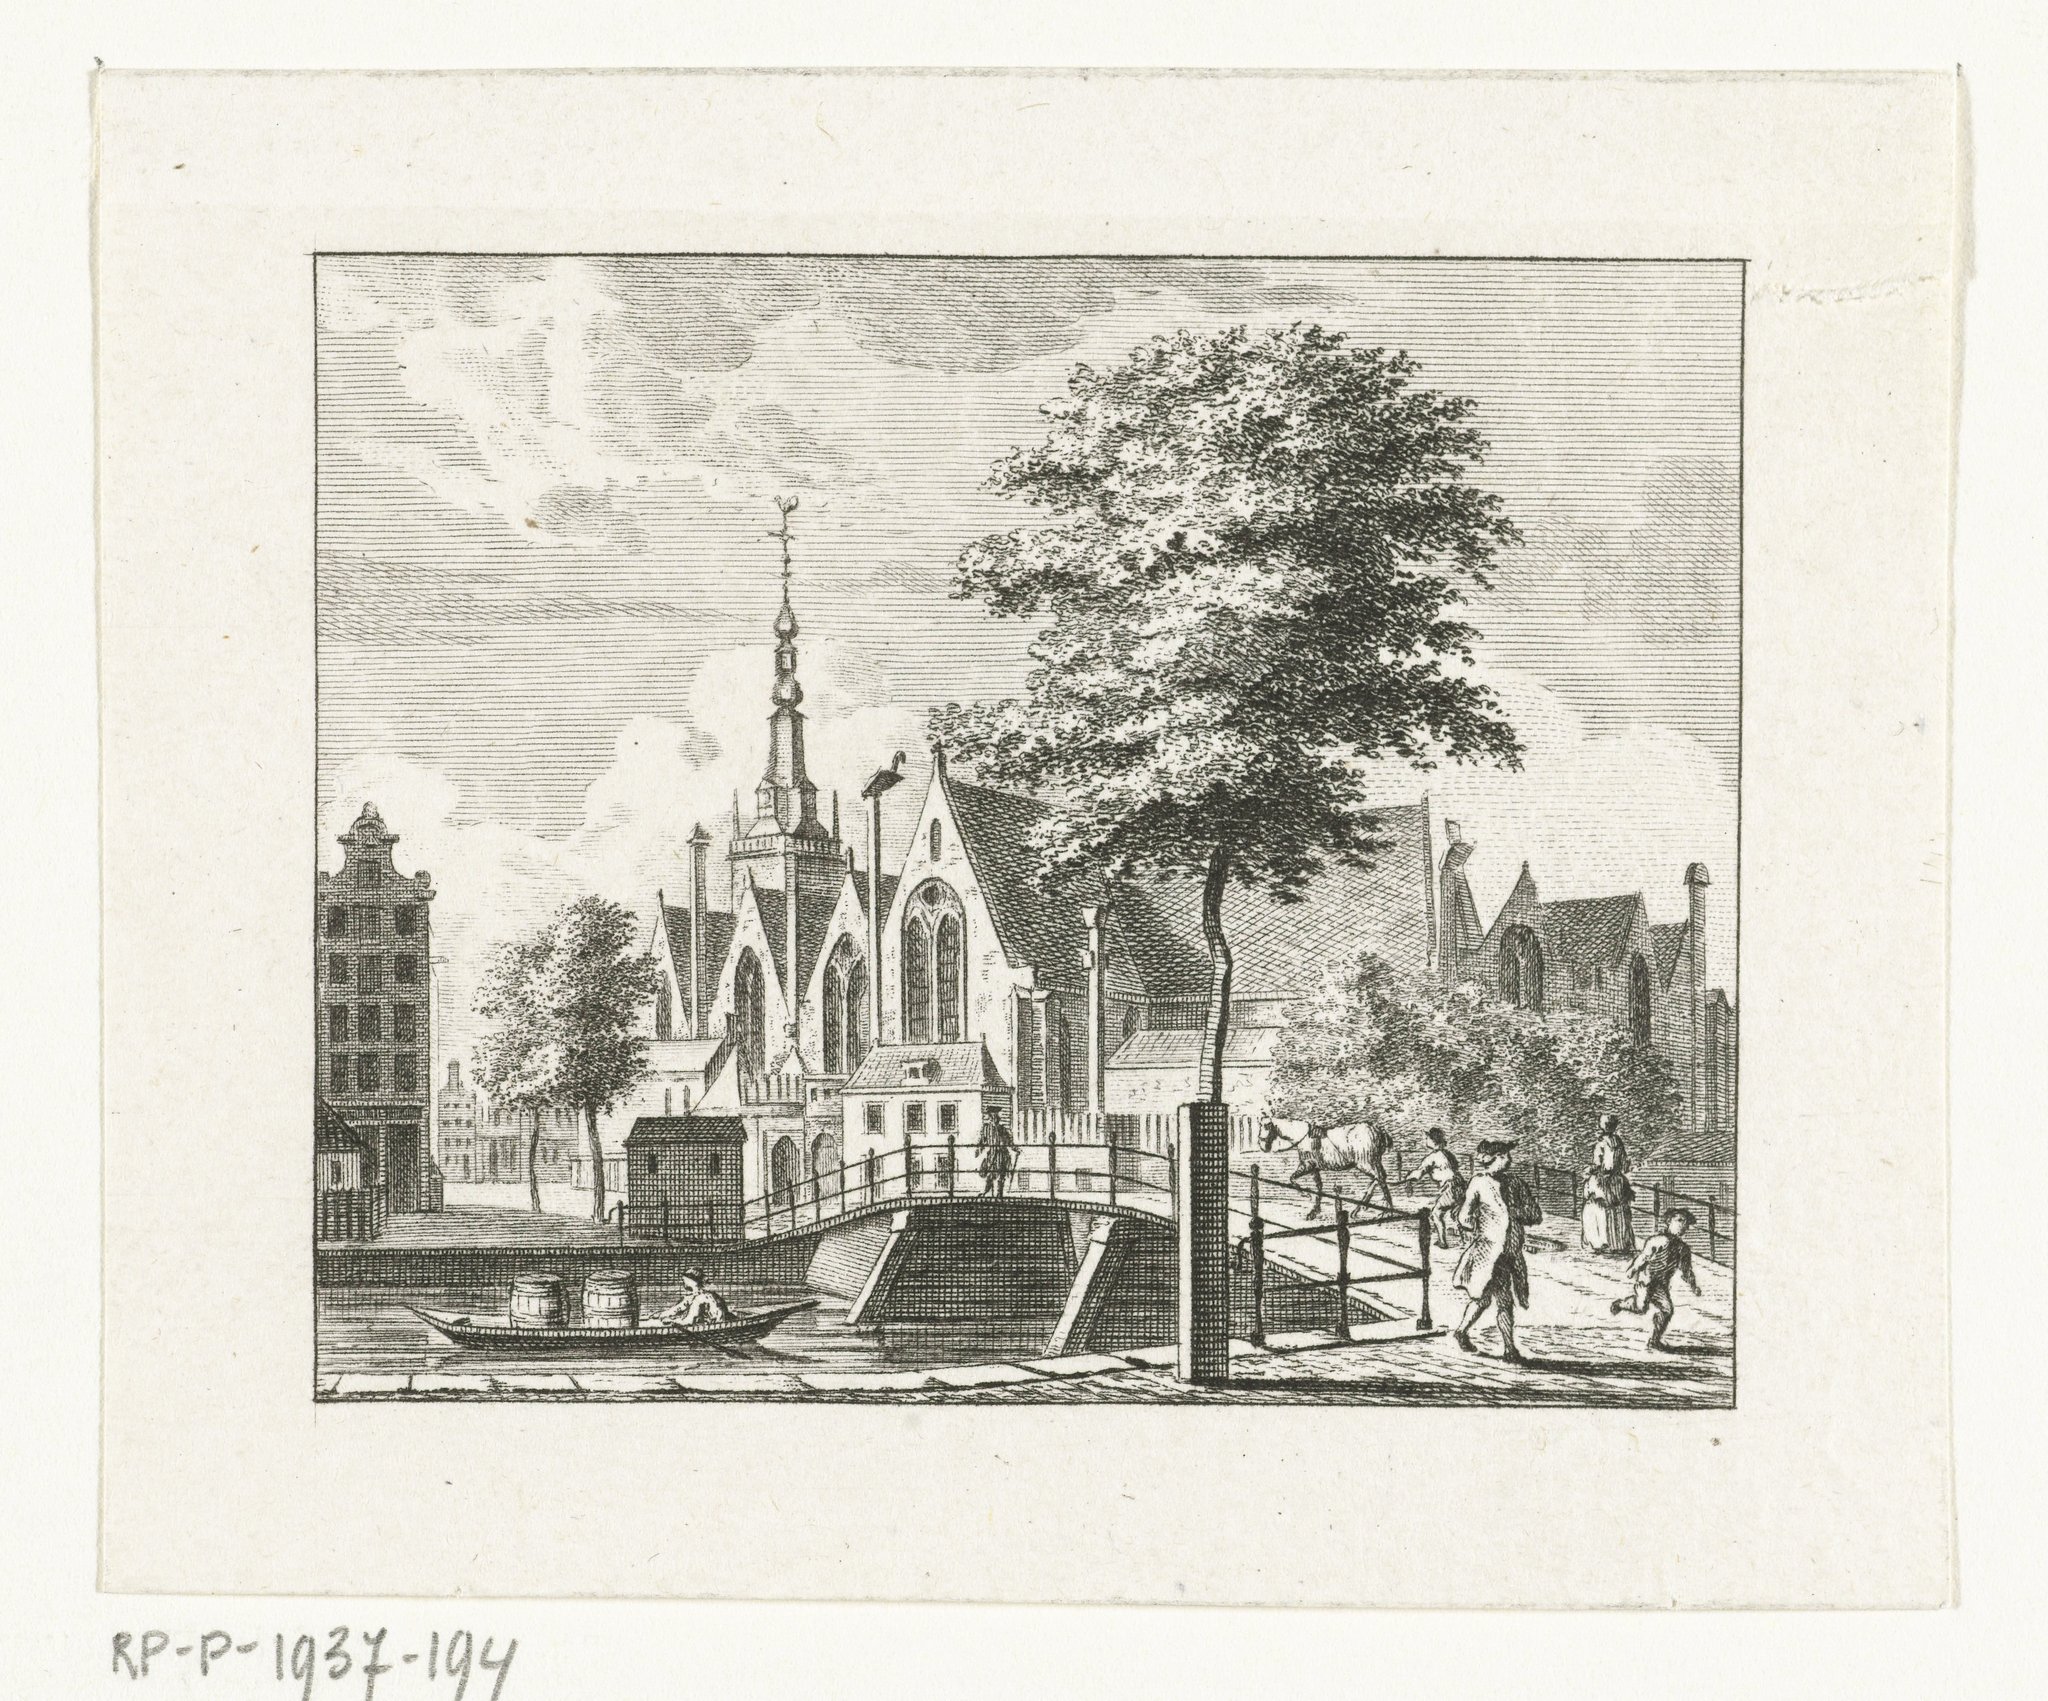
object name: print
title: Stadsgezicht met Oude Kerk te Amsterdam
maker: cornelis brouwer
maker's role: print maker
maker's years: 1731-1803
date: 1782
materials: paper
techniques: etching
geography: netherlands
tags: city-view in general; 'veduta'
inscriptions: collector's mark: Lugt 2228, collector's mark: Lugt 2760